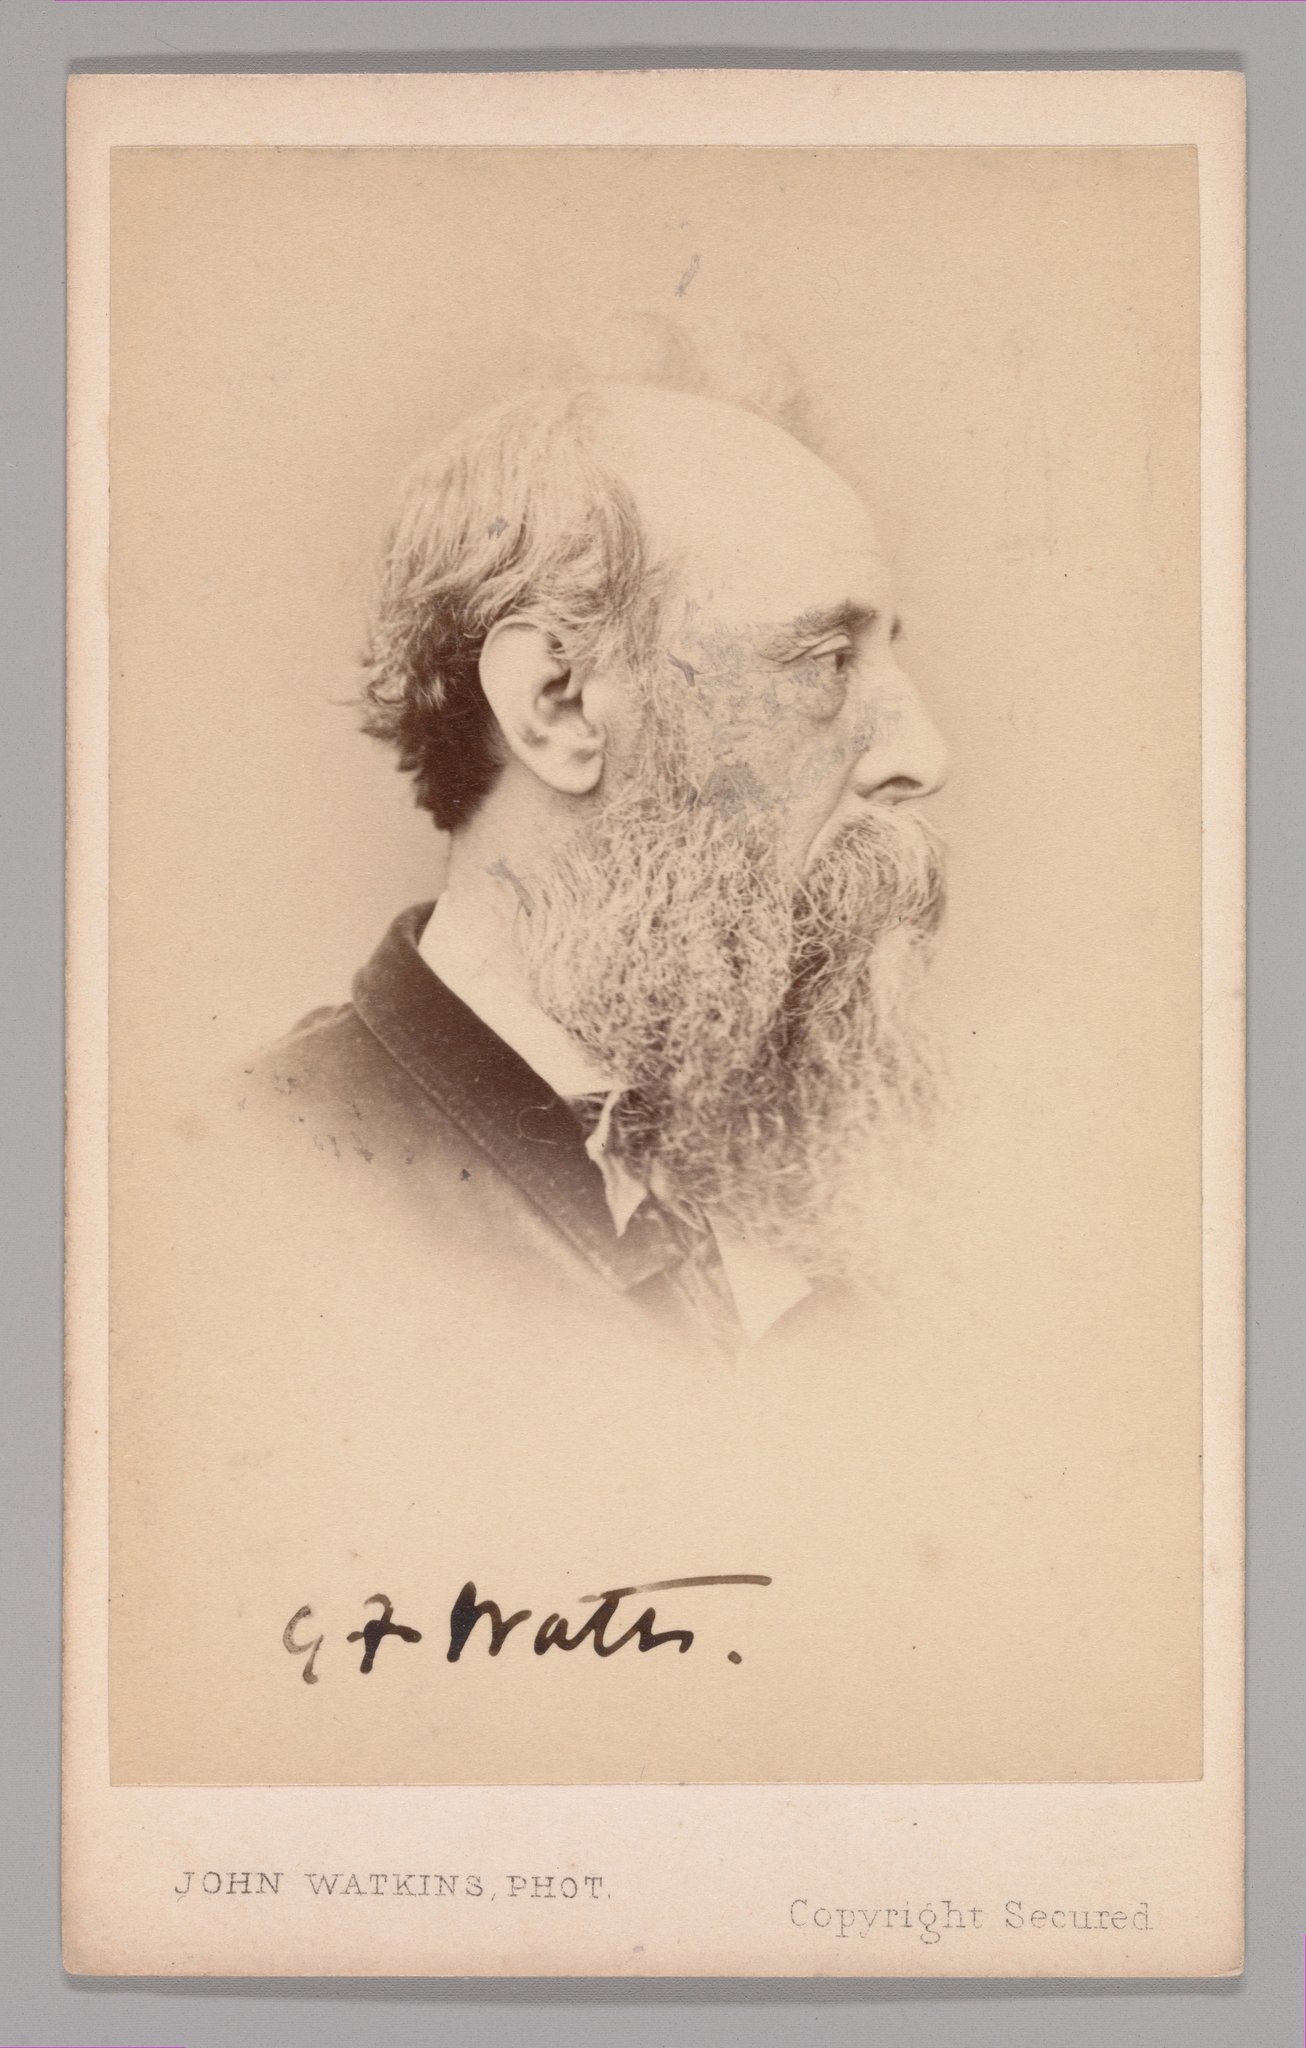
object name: carte de visite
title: [George Frederick Watts]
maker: john and charles watkins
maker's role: photography studio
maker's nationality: british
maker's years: 1840-1875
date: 1860-1869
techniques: albumen silver print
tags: men,portraits,profiles